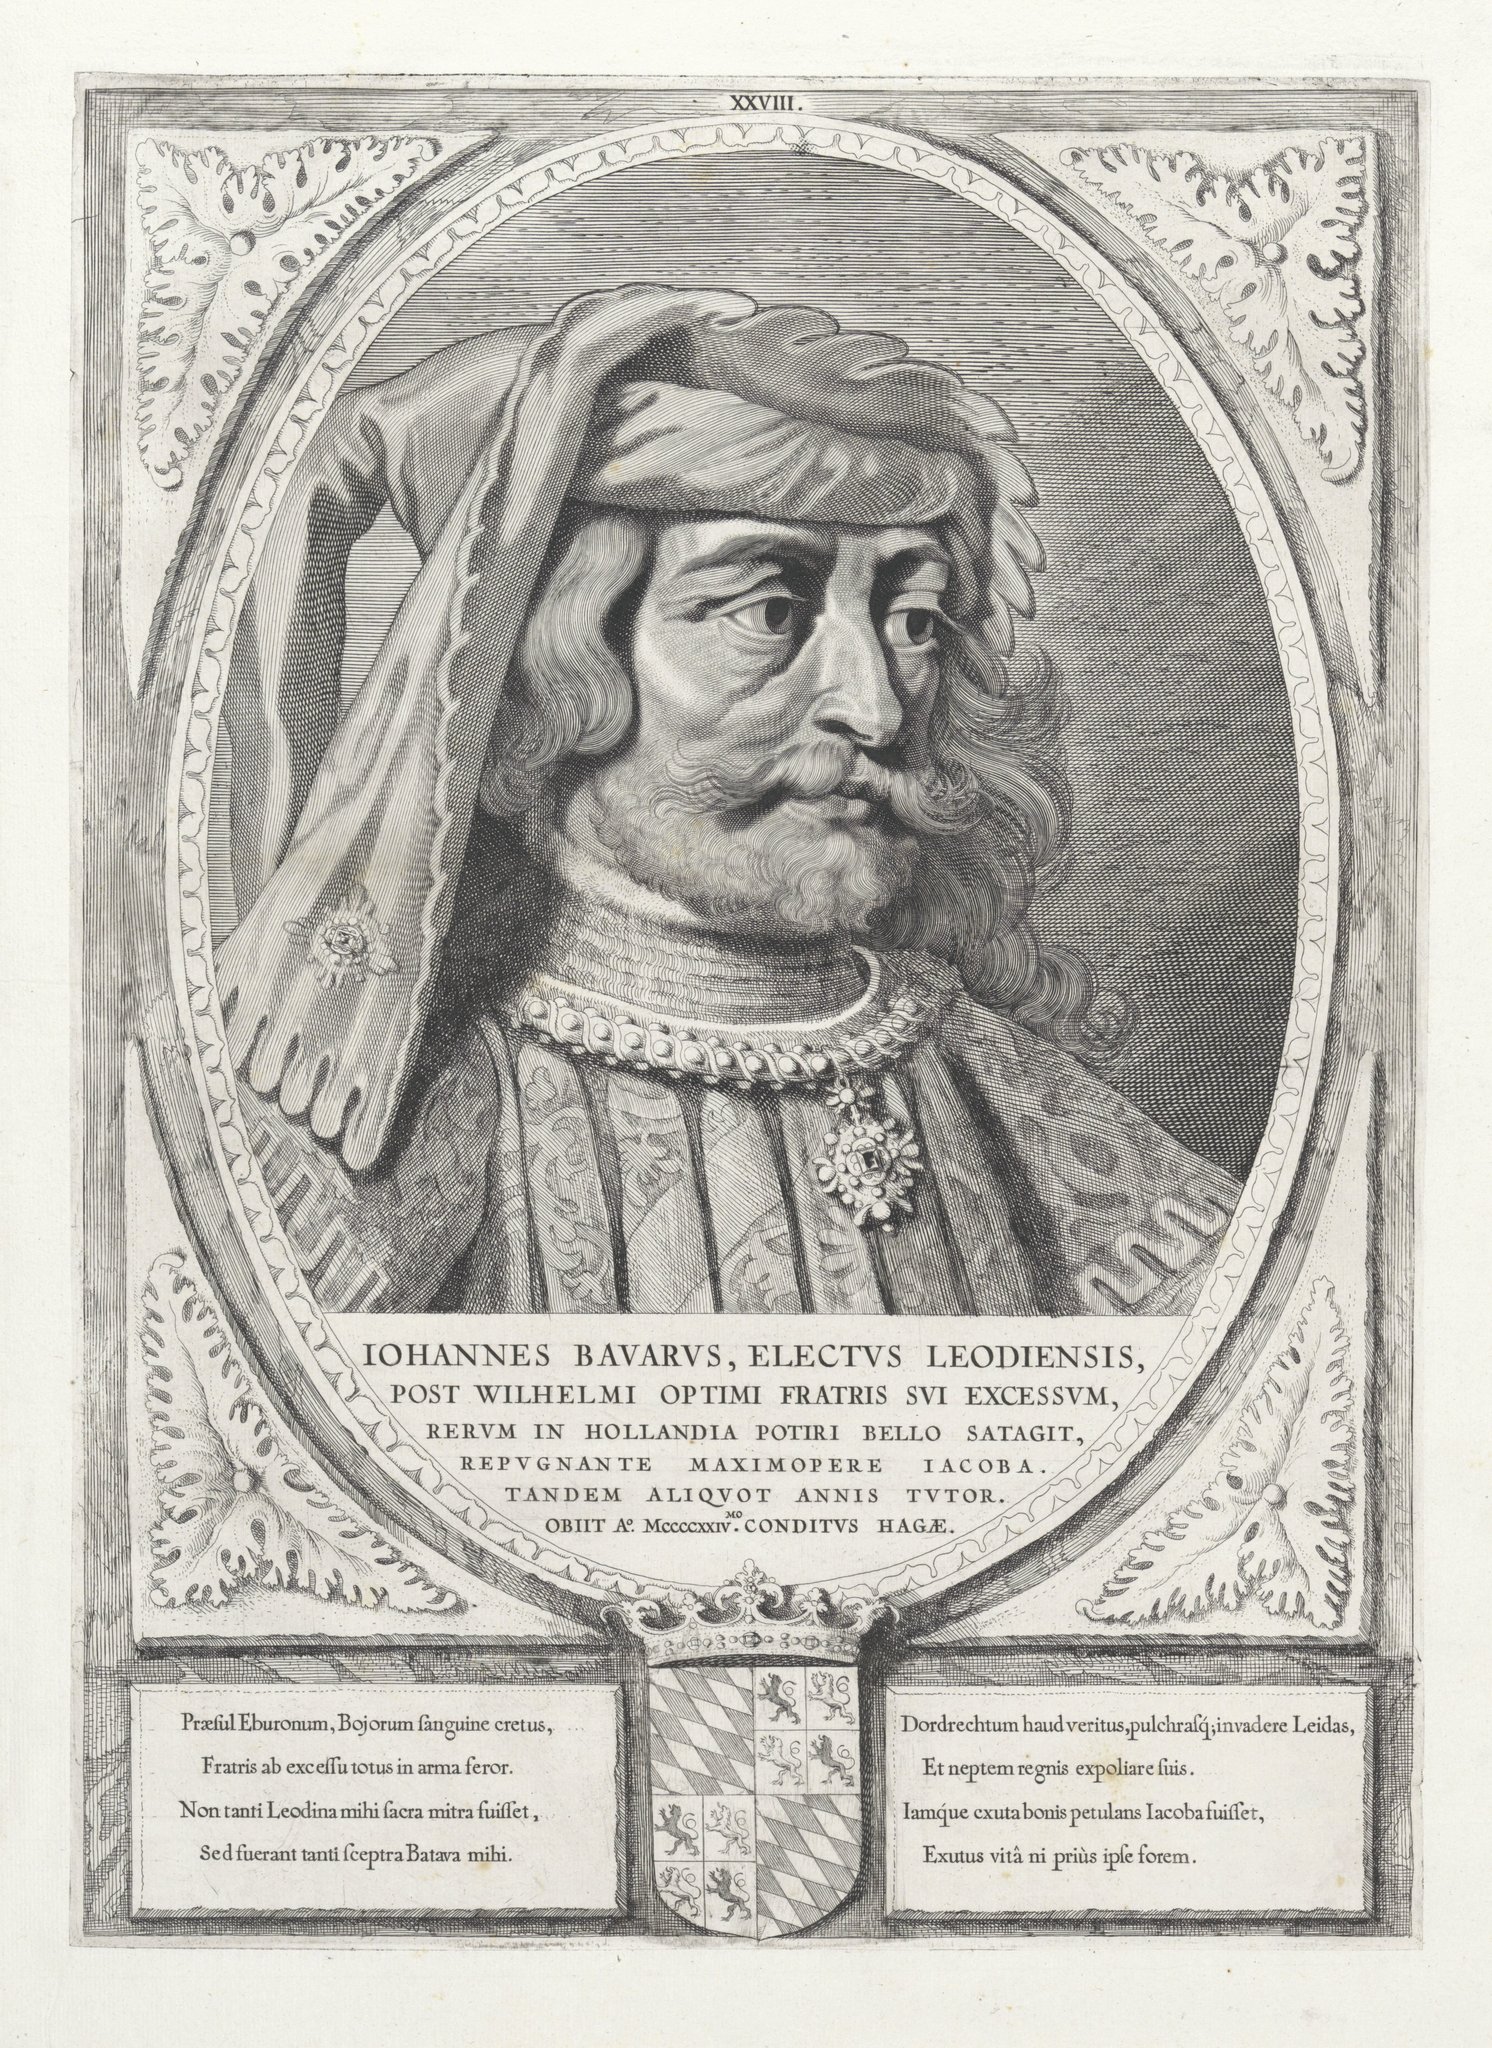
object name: print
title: Portret van Jan van Beieren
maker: cornelis visscher (ii)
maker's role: draughtsman, painter, print maker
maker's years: 1628-1658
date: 1650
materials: paper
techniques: engraving, etching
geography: haarlem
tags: nobility and patriciate; chivalry, knighthood, necklace (+ men's clothes)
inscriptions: collector's mark: Lugt 12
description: Jan van Beieren, graaf van Holland en Zeeland, bijgenaamd Jan zonder Genade. Om zijn hals een met parels en edelstenen versierde keten. De omlijsting is versierd met een wapen.